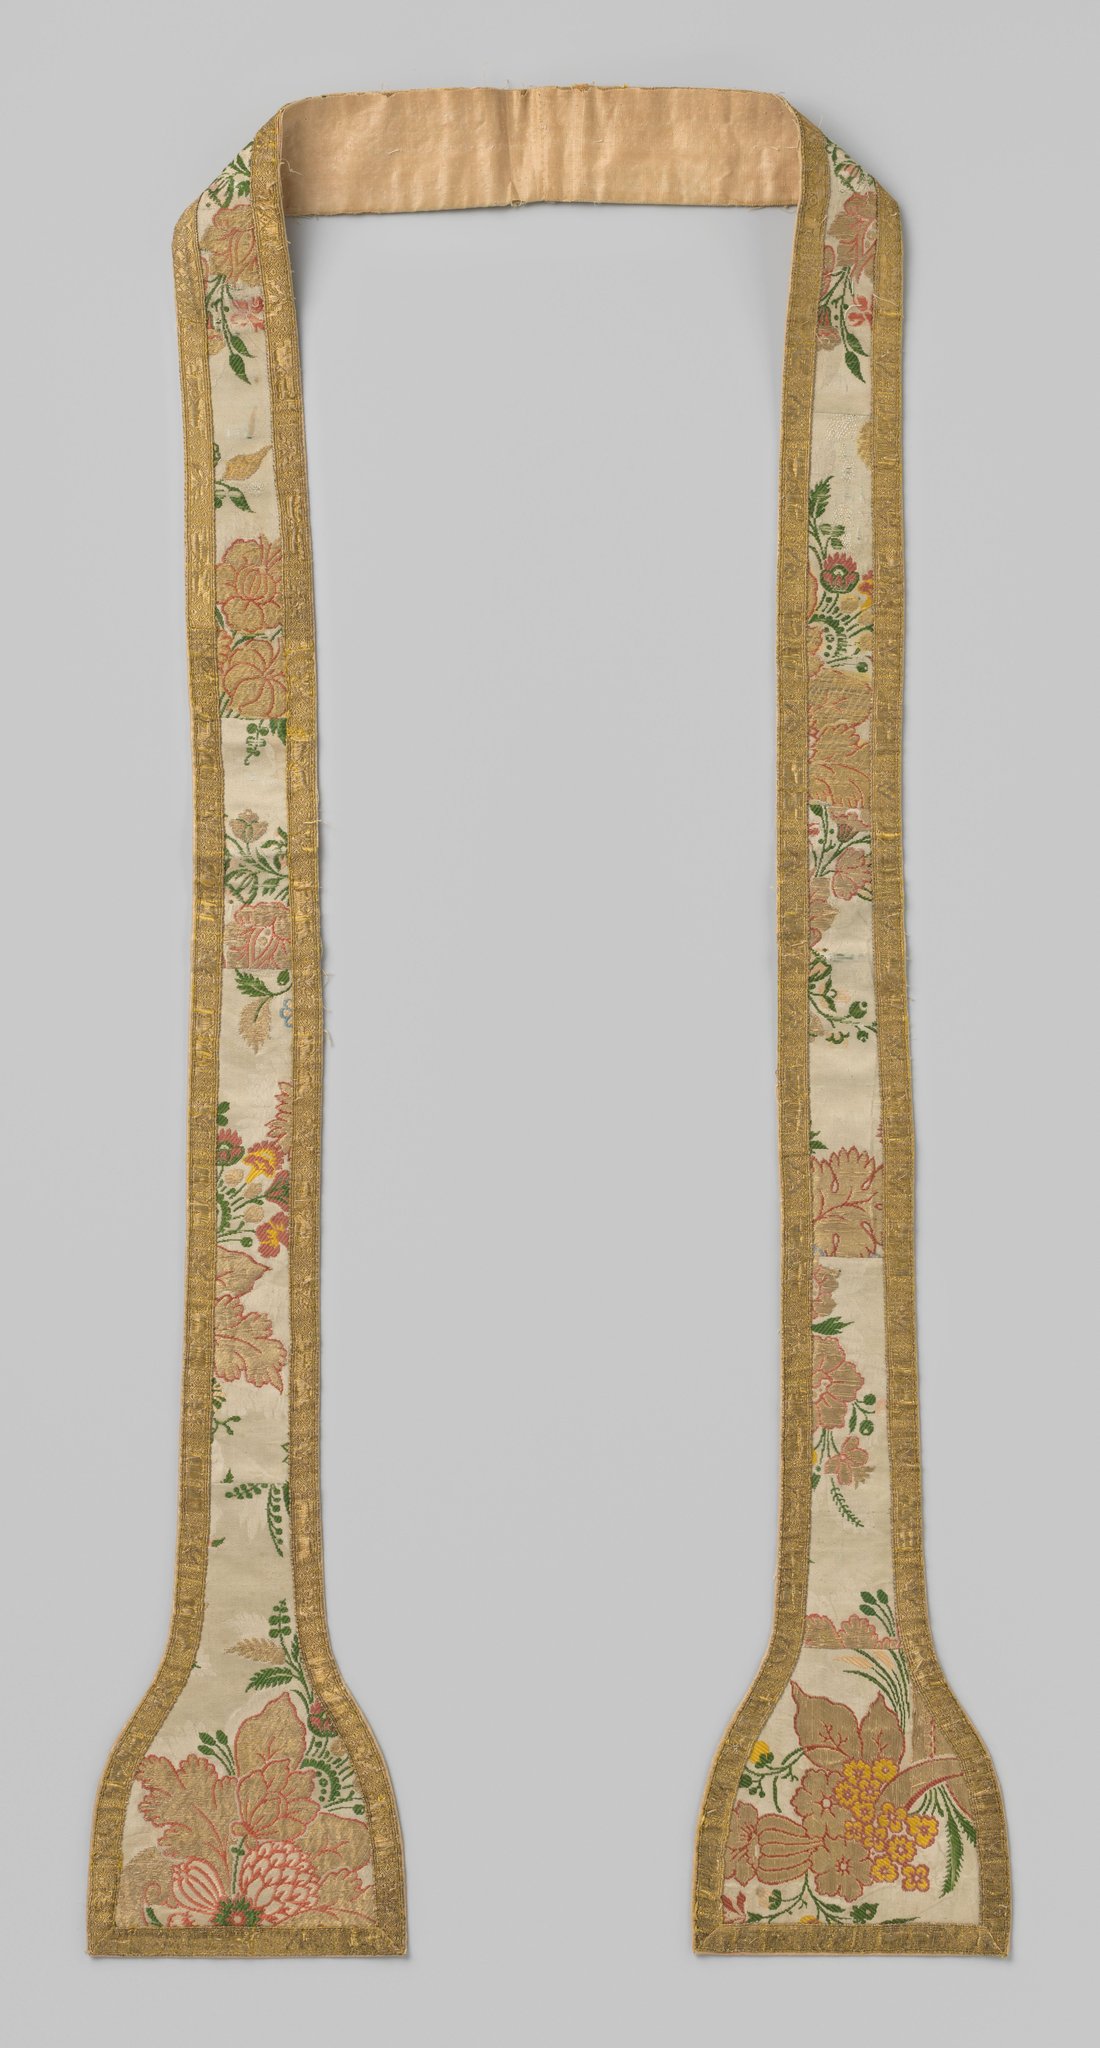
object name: stole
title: Stola van goudbrokaat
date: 1700-1725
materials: textile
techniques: brocade, embroidered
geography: france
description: Stola van goudbrokaat. De stola heeft knotsvormige einden (van de priester). Bij de stola hoort een stola met invnr. BK-1972-1-F. Beide stola's horen bij negen kerkelijke weefsels met borduurwerk met invnrs. BK-1972-1-A t/m BK-1972-1-I en een niet bijbehorende bursa met invnr. BK-1972-1-J.